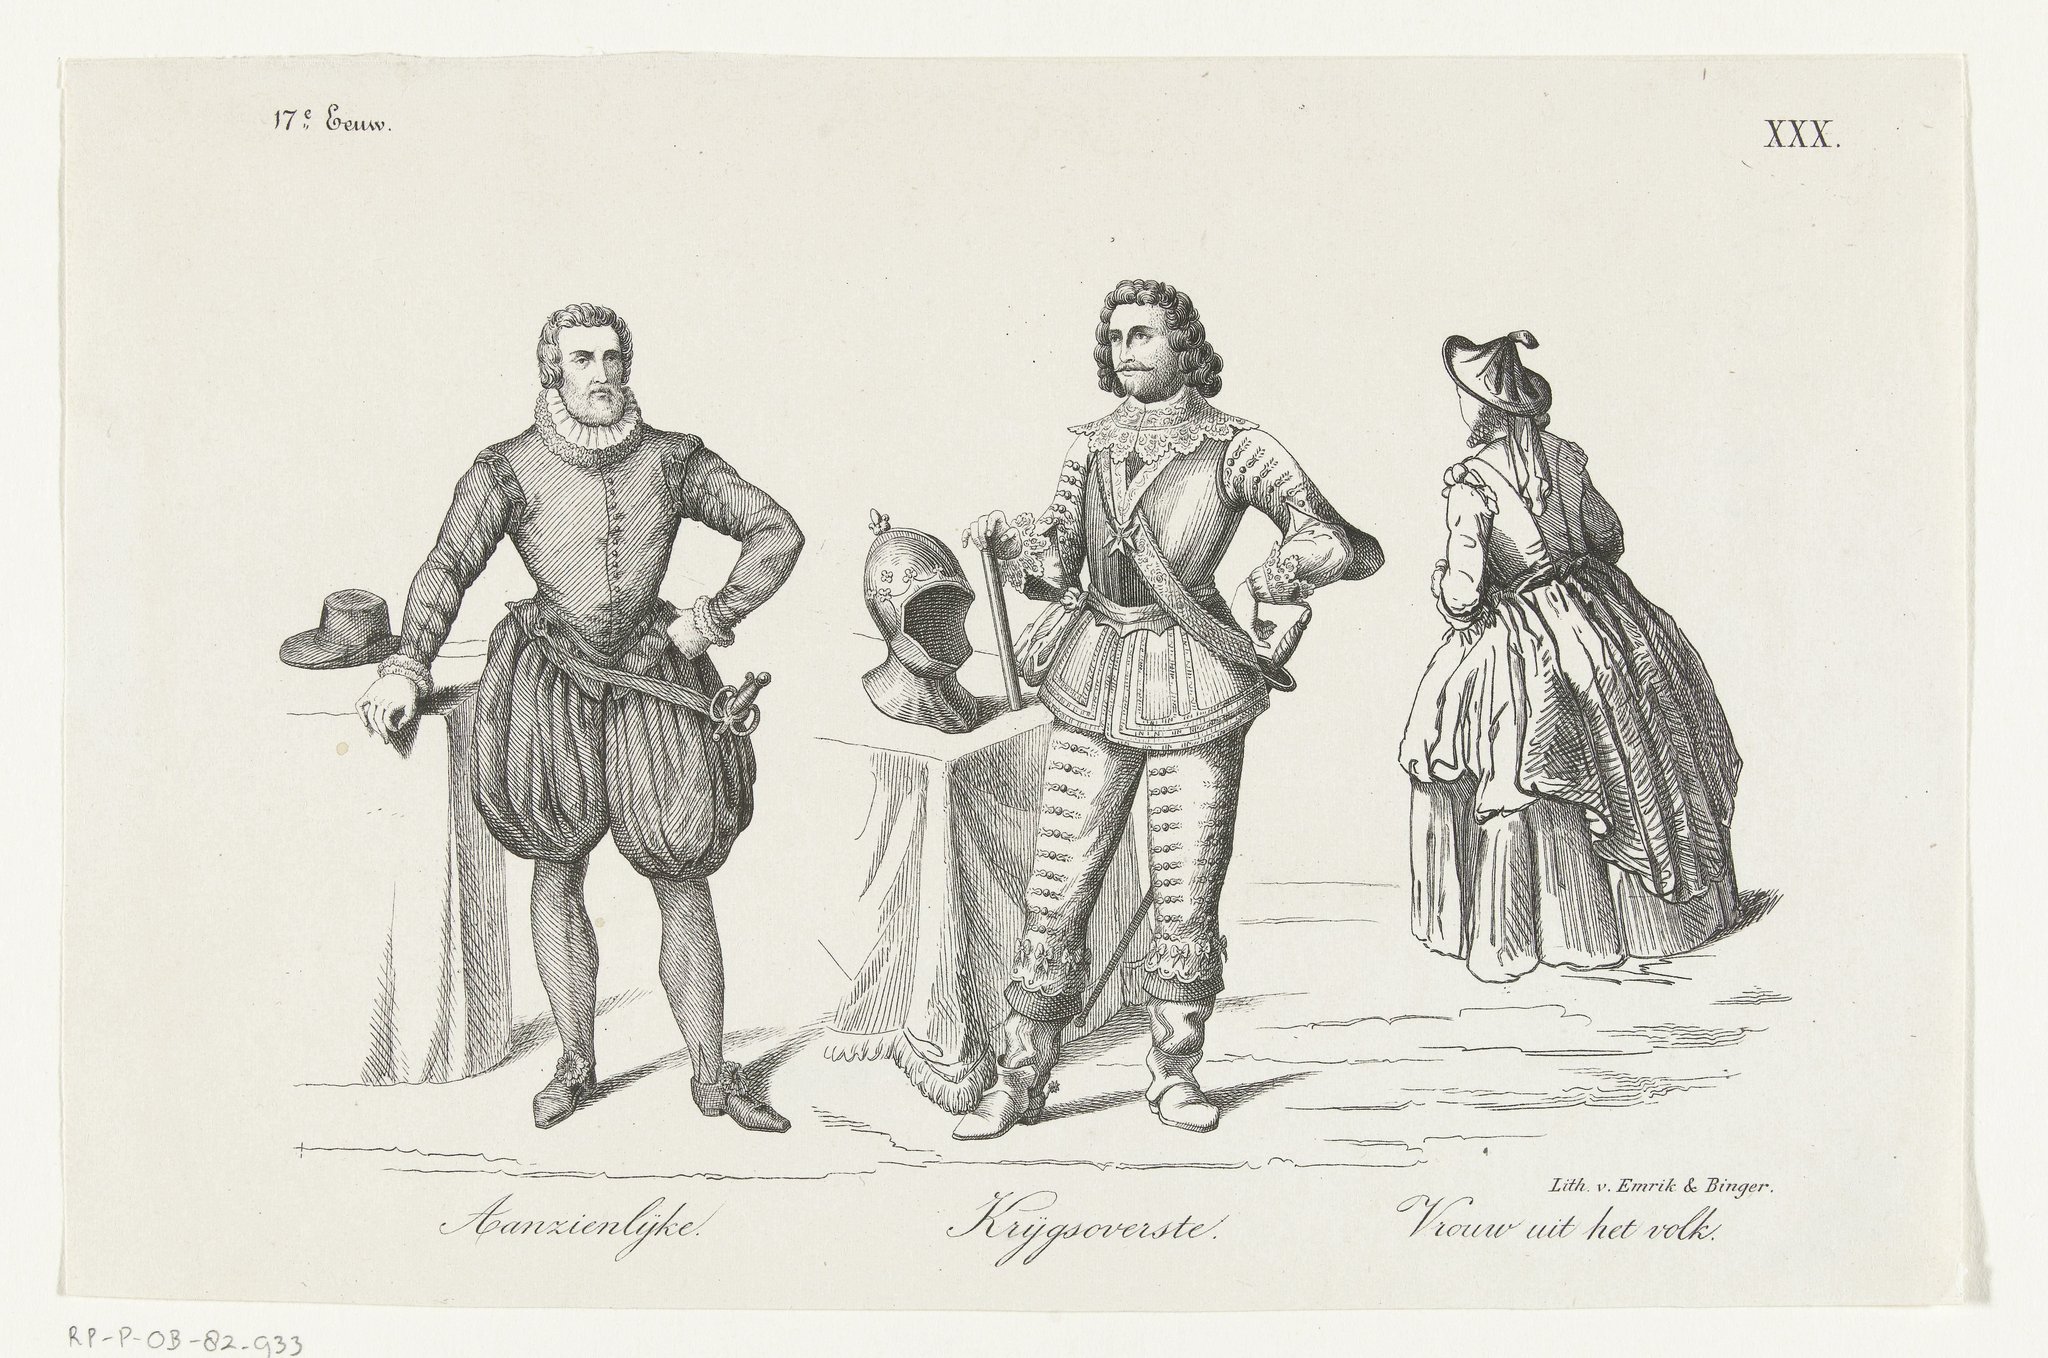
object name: costume print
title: Kleding van Nederlandse mannen en vrouwen in de zeventiende eeuw, plaat XXX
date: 1855-1857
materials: paper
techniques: lithograph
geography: netherlands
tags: clothes, costume (+ men's clothes)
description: Kleding van Nederlandse mannen en vrouwen in de zeventiende eeuw. Kleding van: Aanzienlijke / Krijgsoverste / Vrouw uit het volk. Genummerd rechtsboven: XXX.